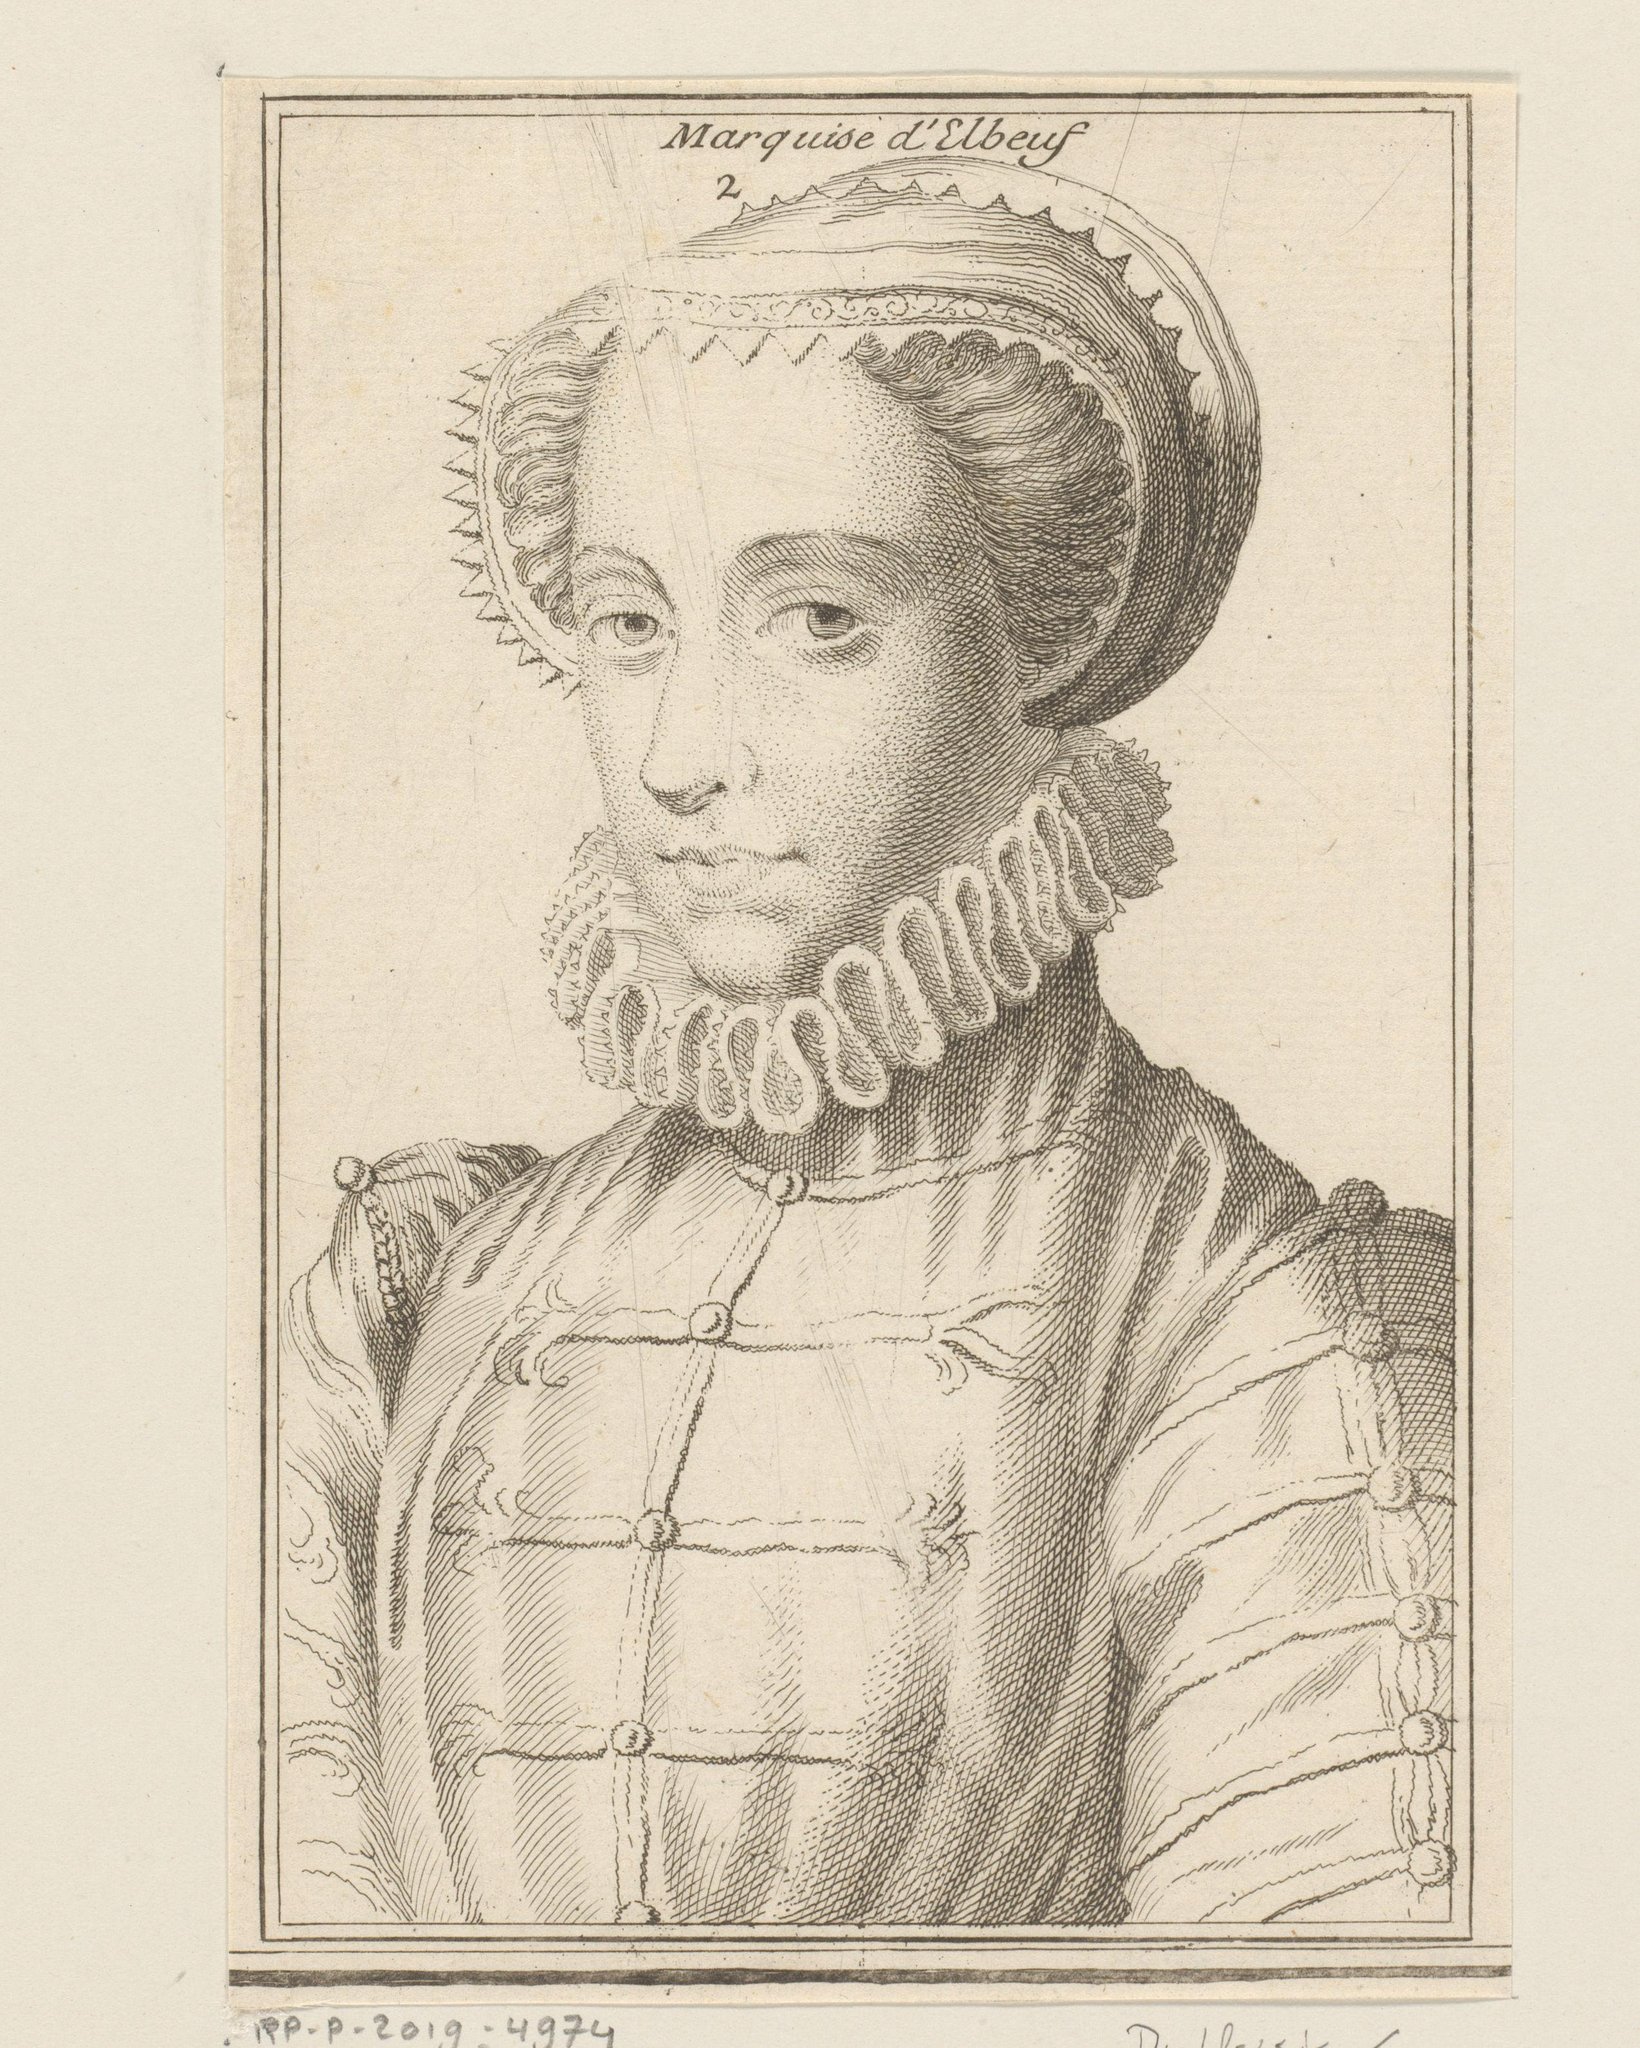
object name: print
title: Portret van Louise de Rieux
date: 1729-1733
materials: paper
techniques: etching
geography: paris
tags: historical persons - bb - woman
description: Prent uit: Montfaucon, Bernard de. Les monumens de la Monarchie Françoise (...). Parijs: Julien-Michel Gandouin en Pierre-François Giffart, 1729-1733.